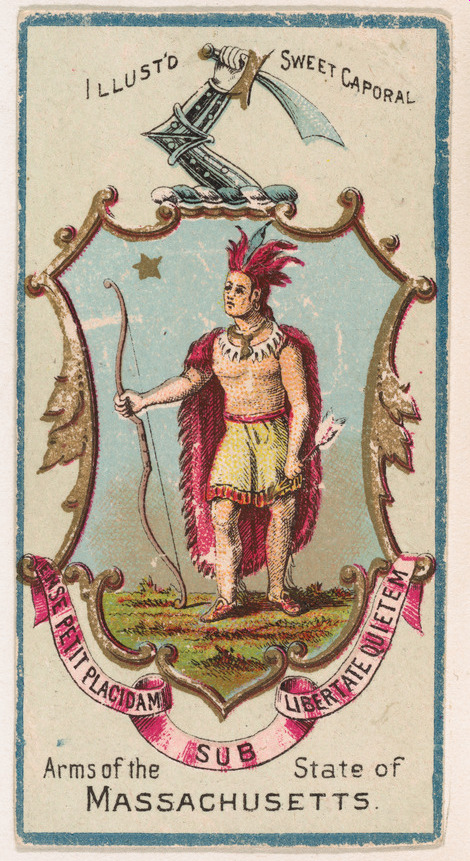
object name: print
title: Arms of the State of Massachusetts, from the Military Series (N224) issued by Kinney Tobacco Company to promote Sweet Caporal Cigarettes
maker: kinney brothers tobacco company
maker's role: publisher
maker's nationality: american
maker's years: 1869-2011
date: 1888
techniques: color lithograph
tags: men,coat of arms